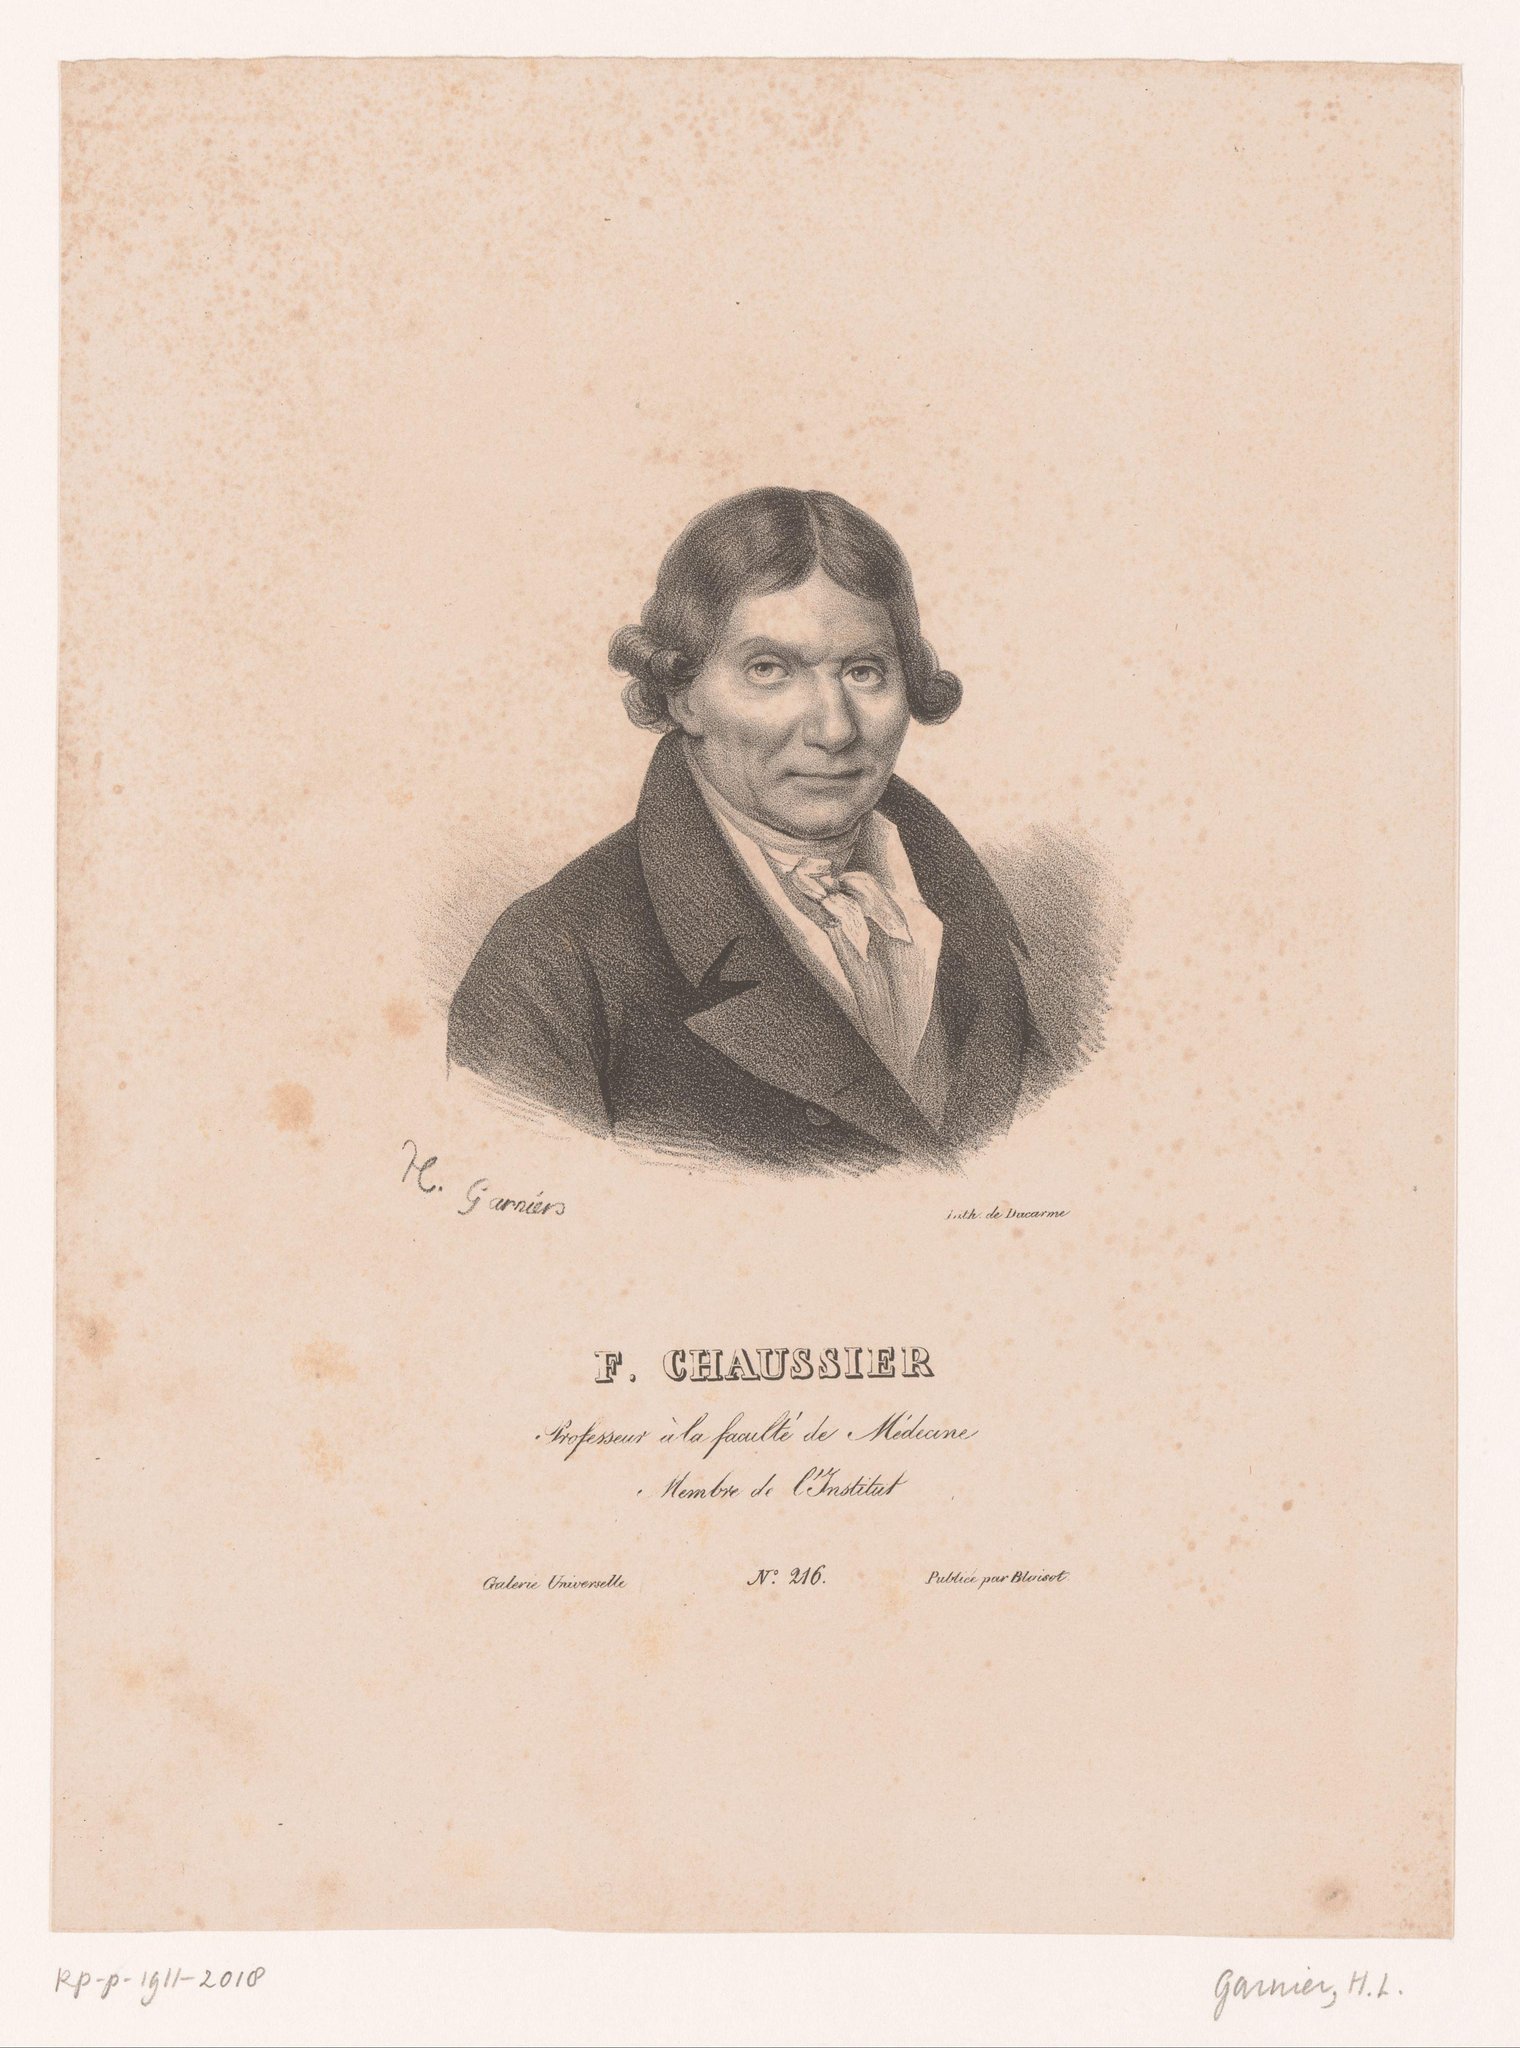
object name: print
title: Portrettengalerij van Blaisot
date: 1823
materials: paper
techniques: lithograph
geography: paris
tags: paris, historical persons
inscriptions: collector's mark: Lugt 2228a